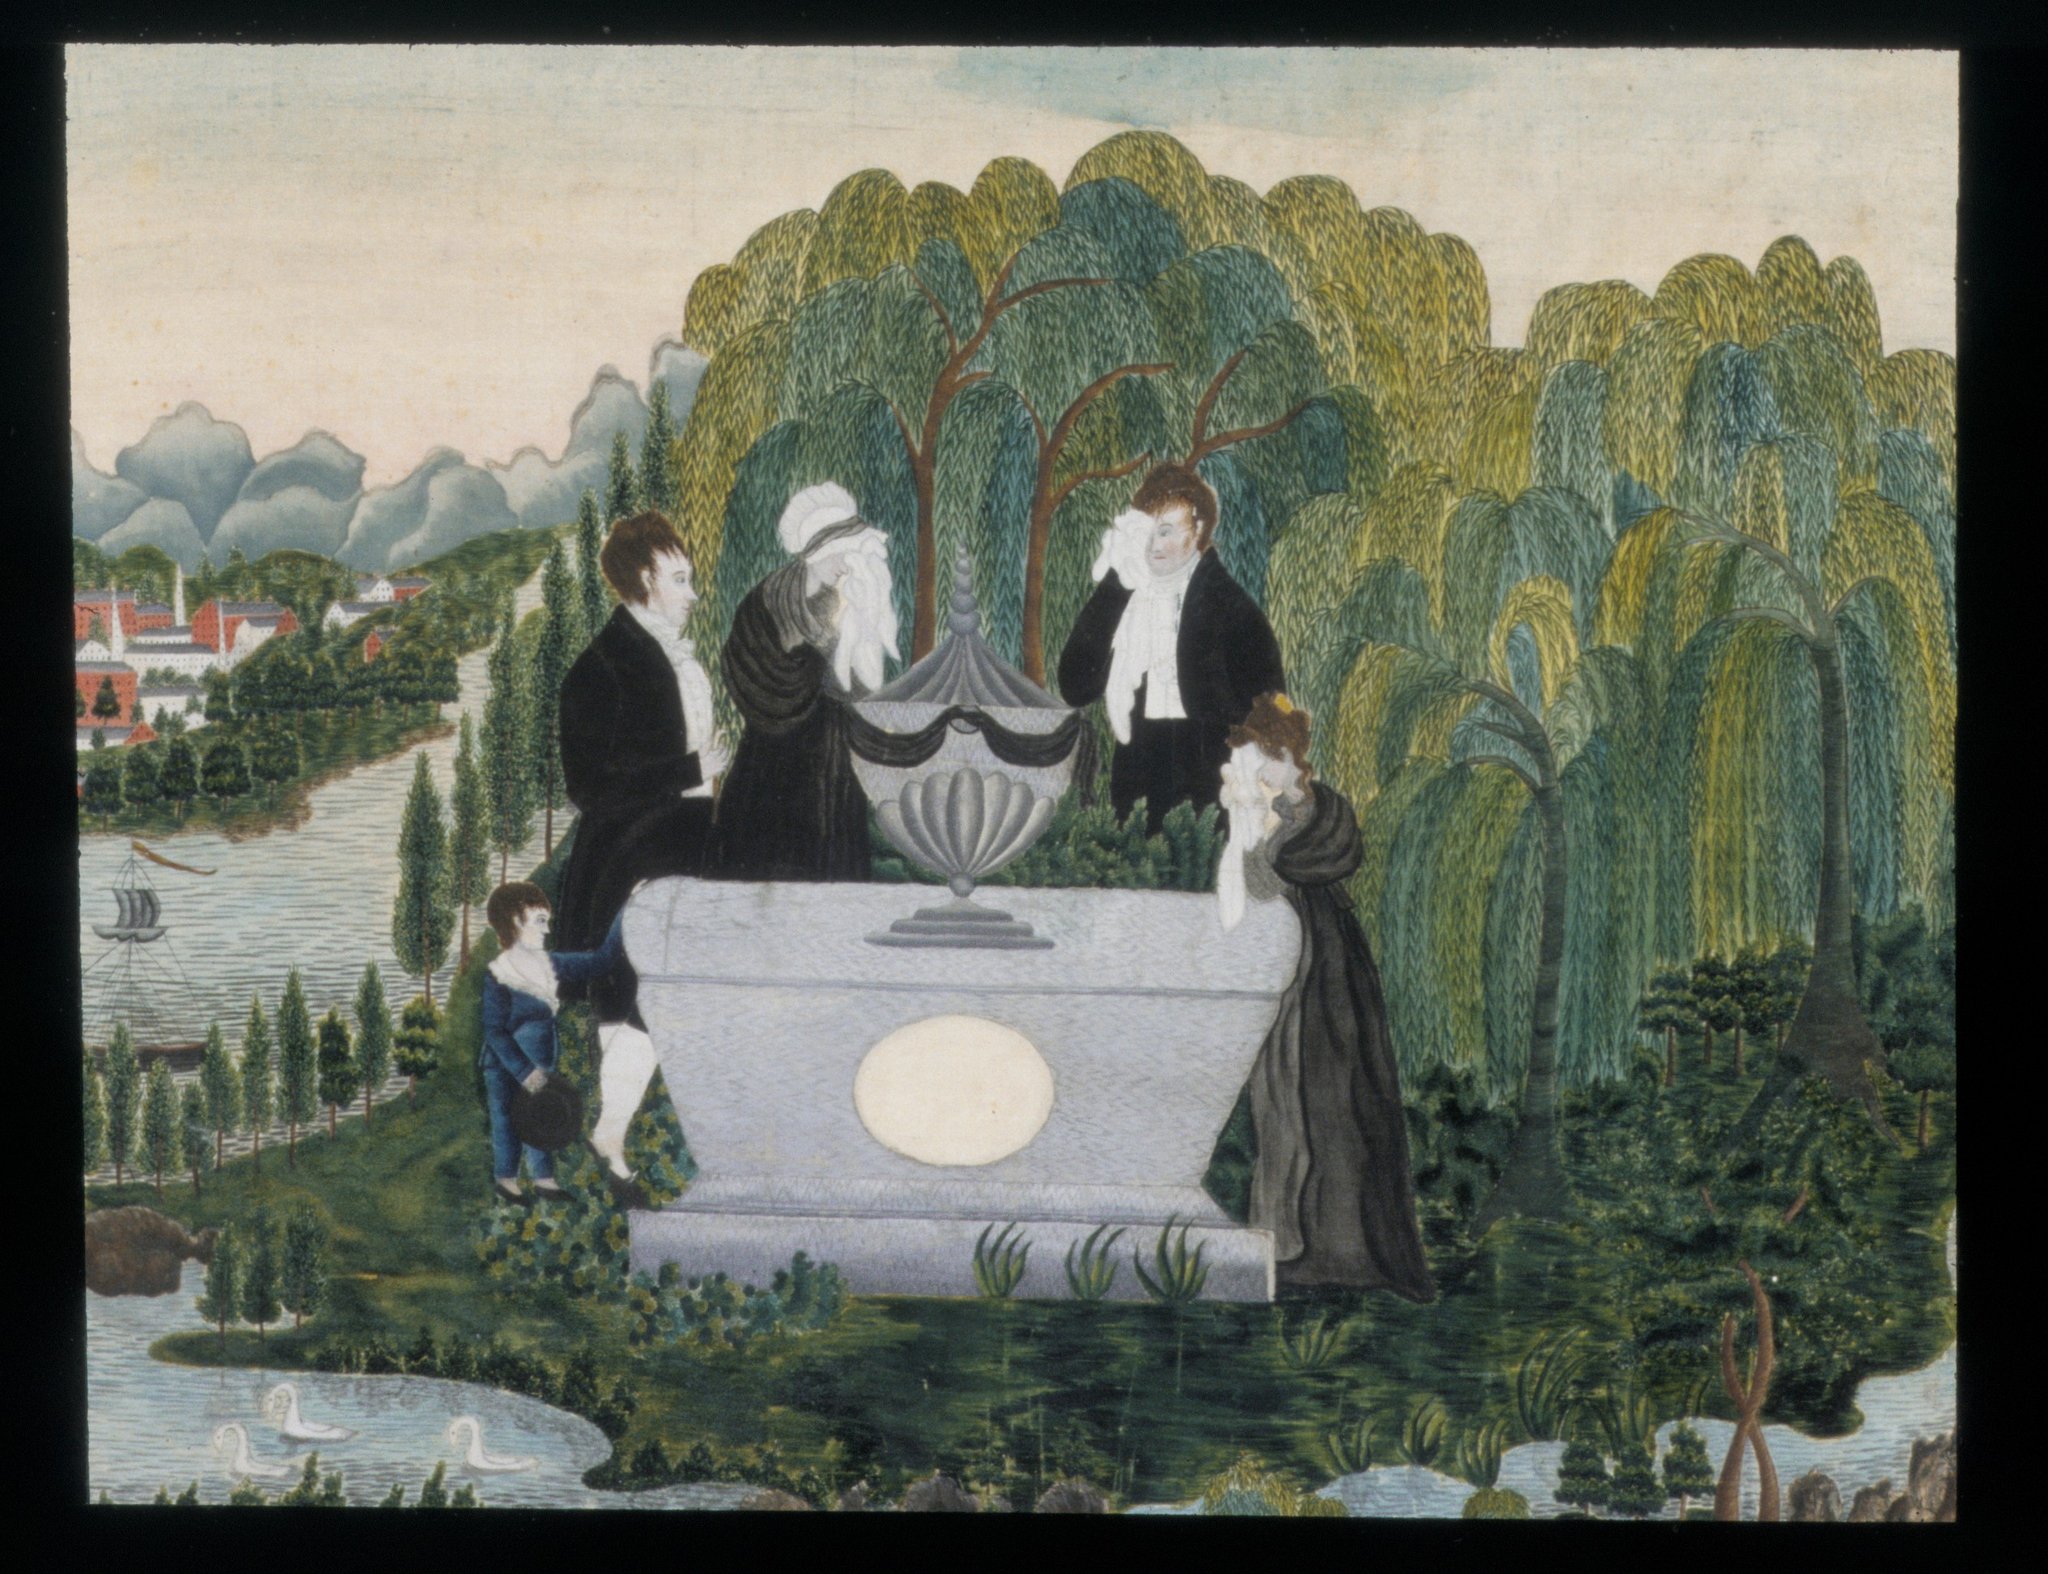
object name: mourning picture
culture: american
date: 1810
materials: gouache, silk, watercolor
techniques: painting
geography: united states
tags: funerary monuments,sadness,children,men,women